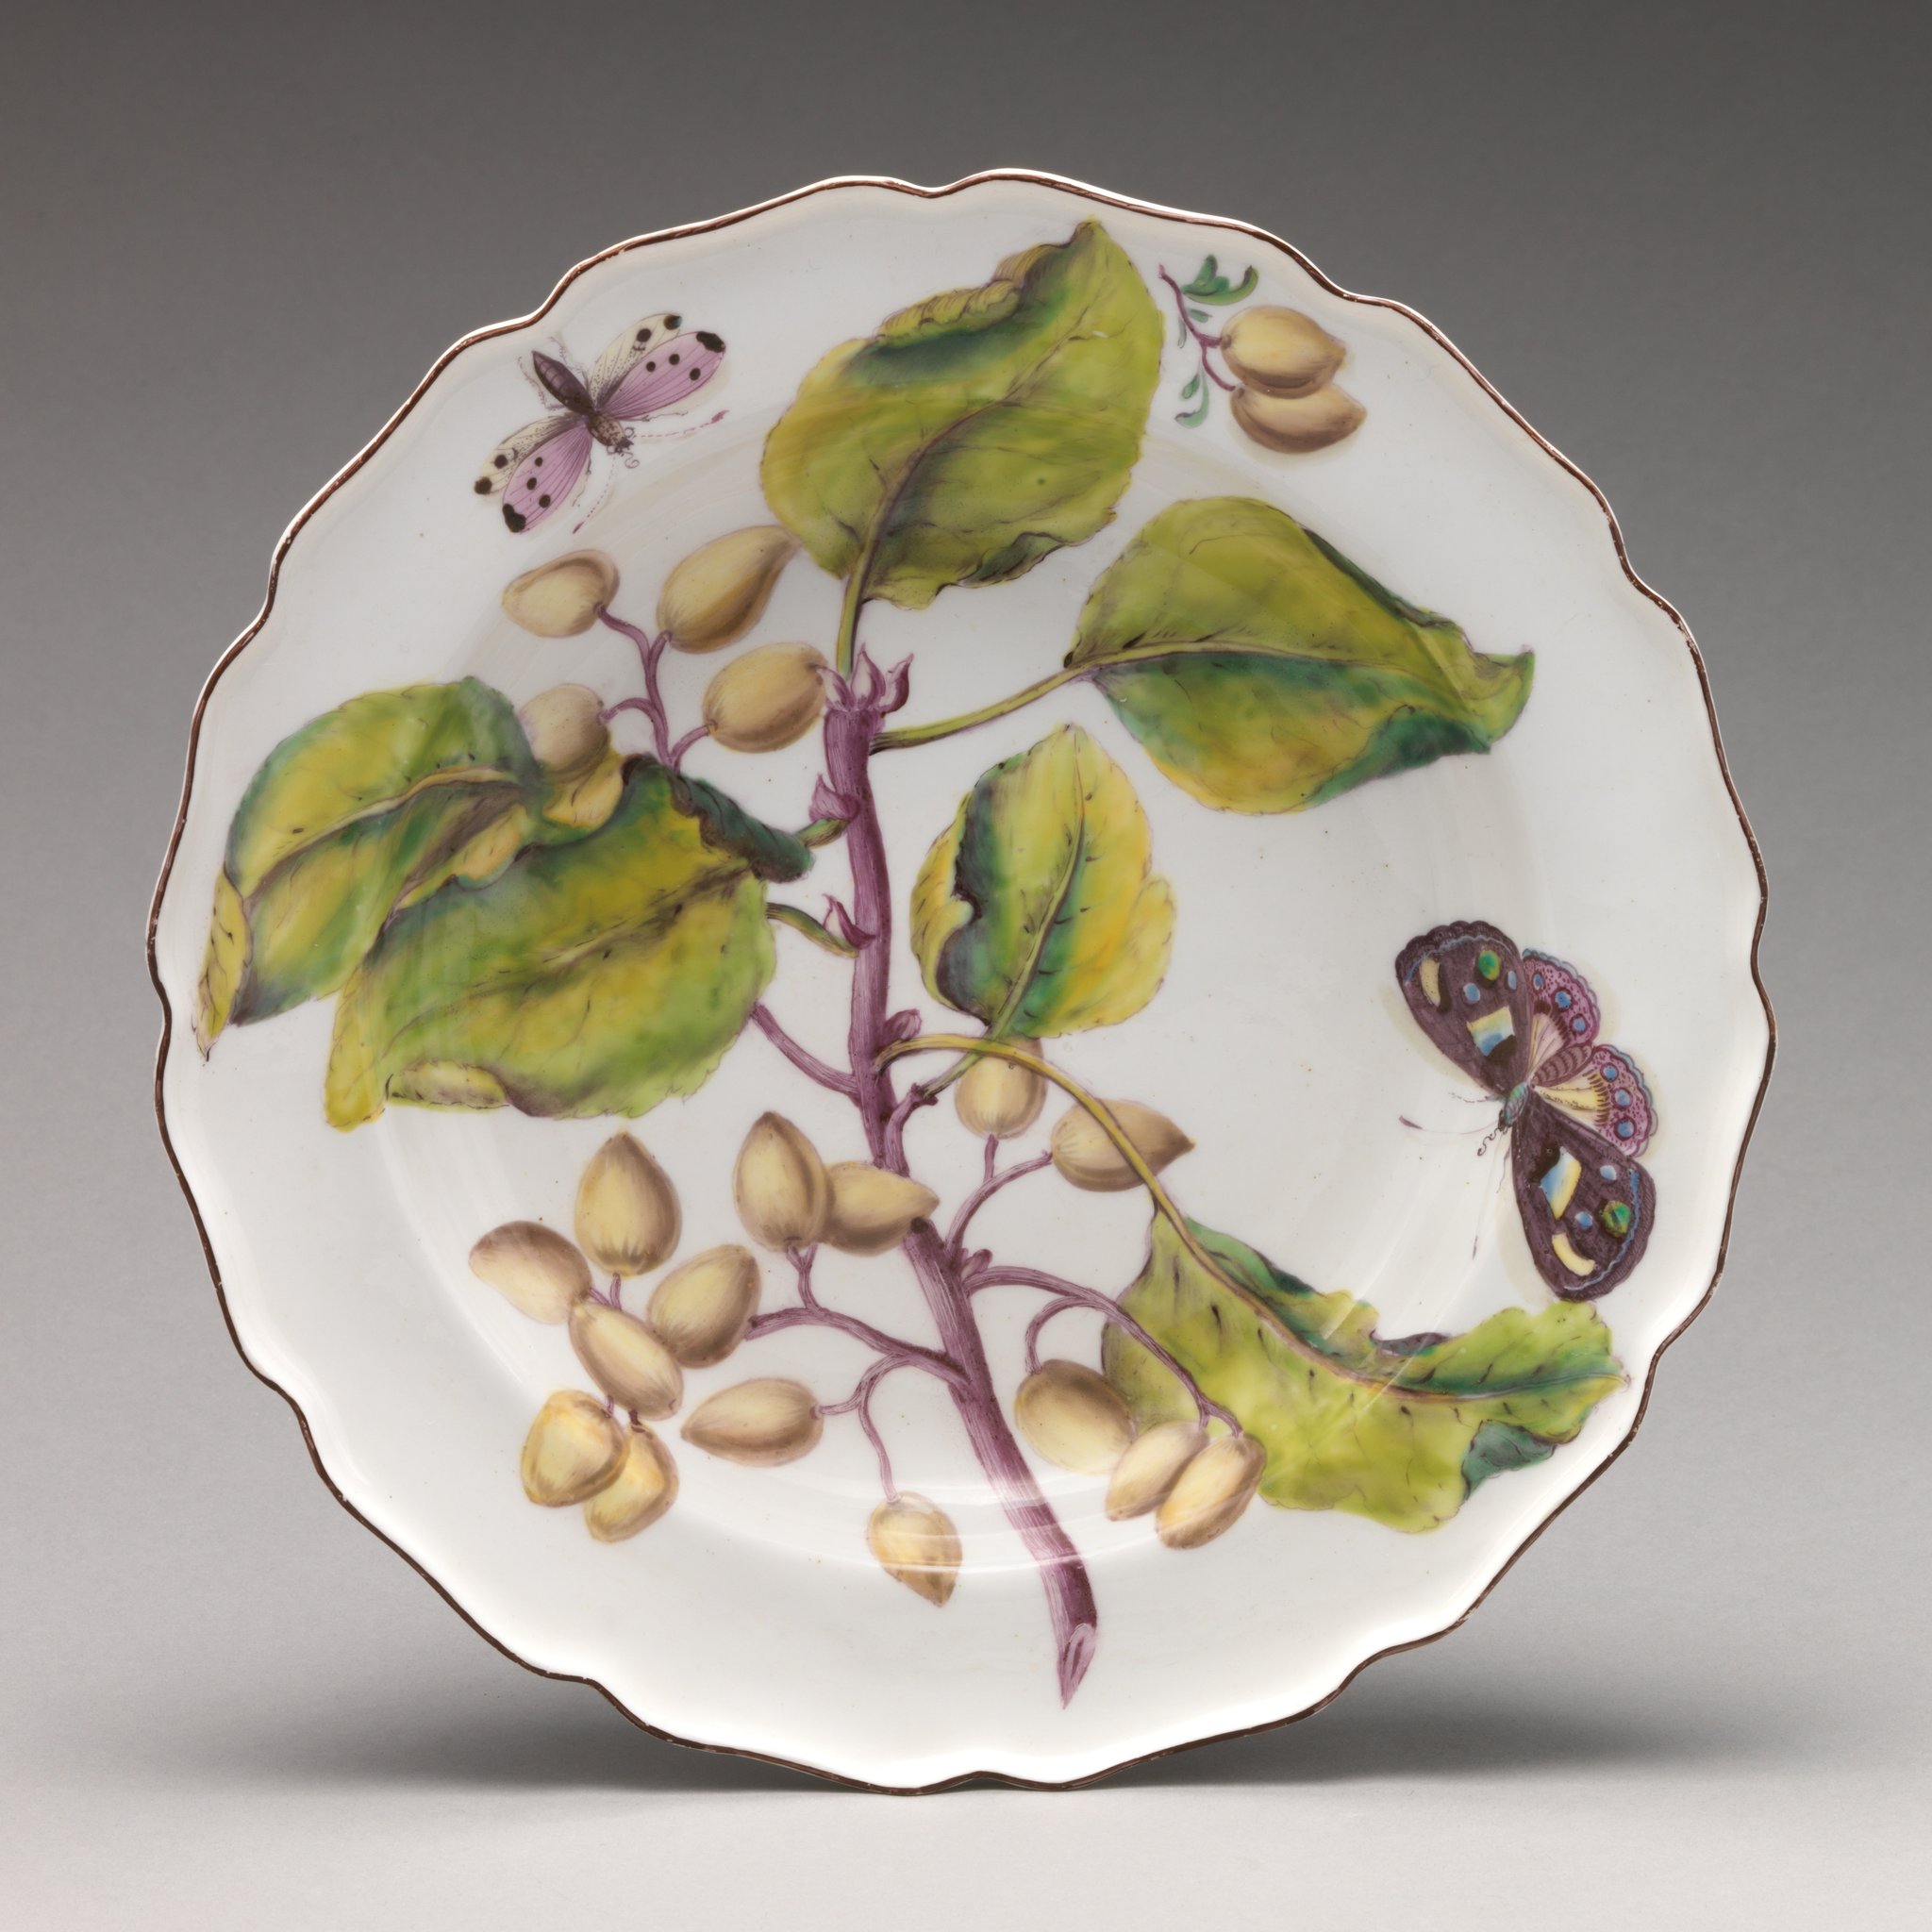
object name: plate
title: Botanical plate with fruiting branch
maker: chelsea porcelain manufactory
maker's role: factory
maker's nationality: british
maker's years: 1744-1784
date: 1755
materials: enamel, soft paste porcelain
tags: fruit,butterflies